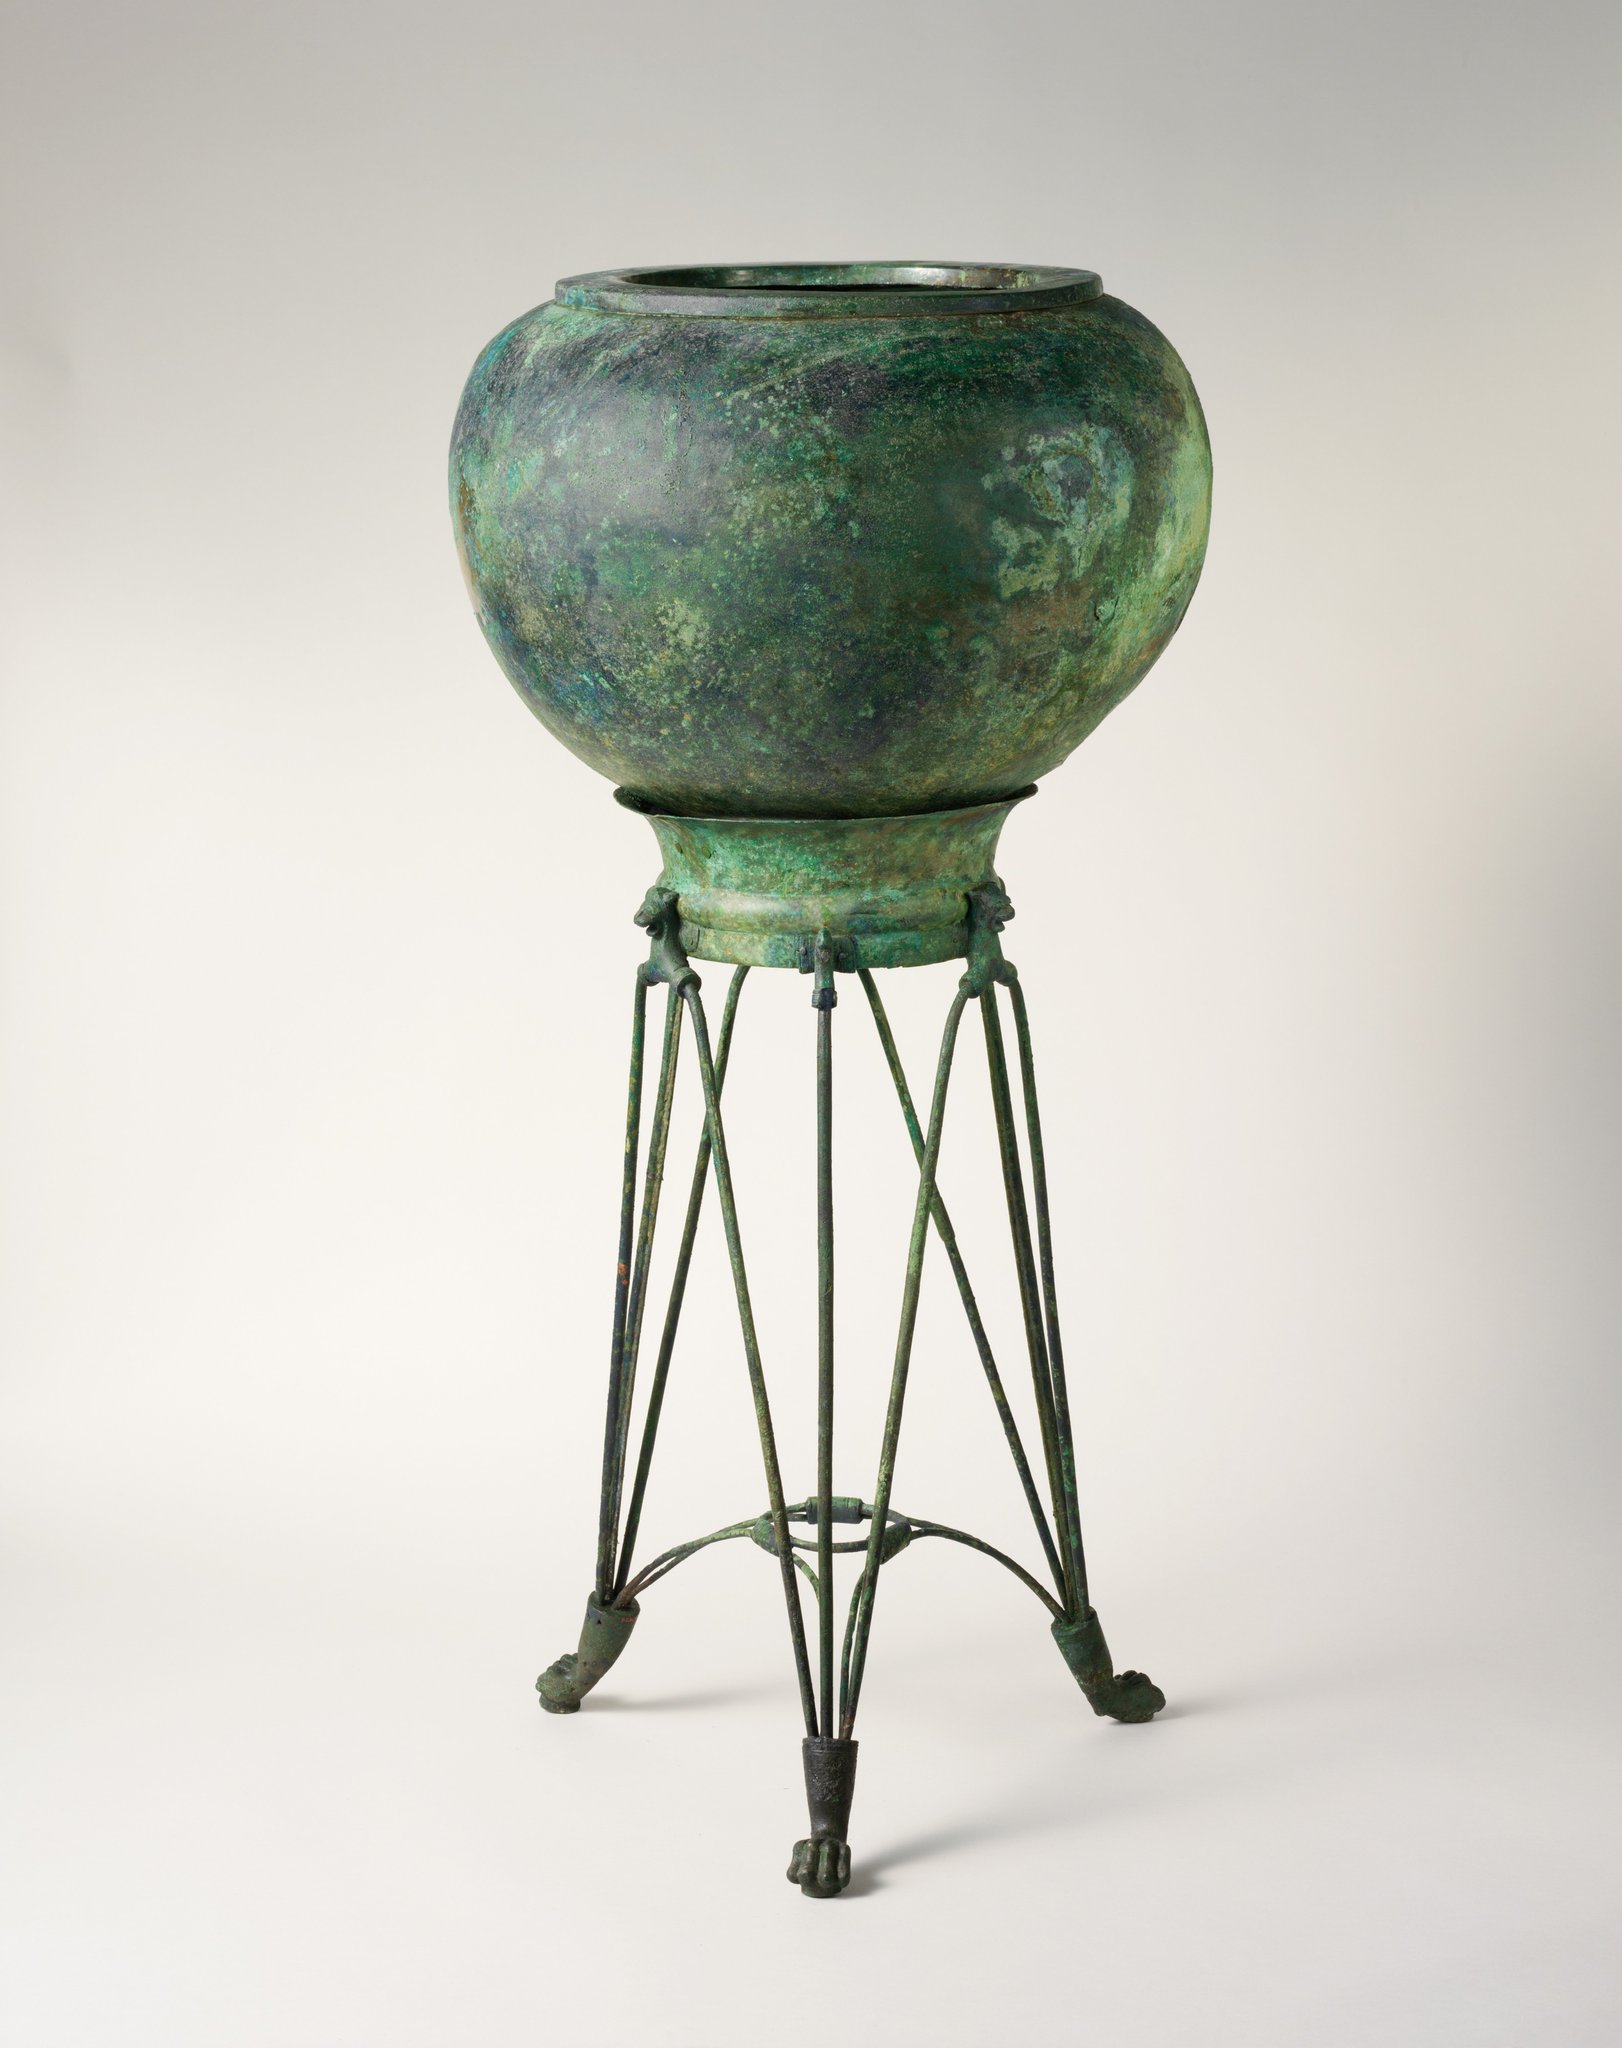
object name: tripod with lebes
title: Bronze tripod and dinos (deep round-bottomed bowl)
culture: etruscan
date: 525-475 BCE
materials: bronze